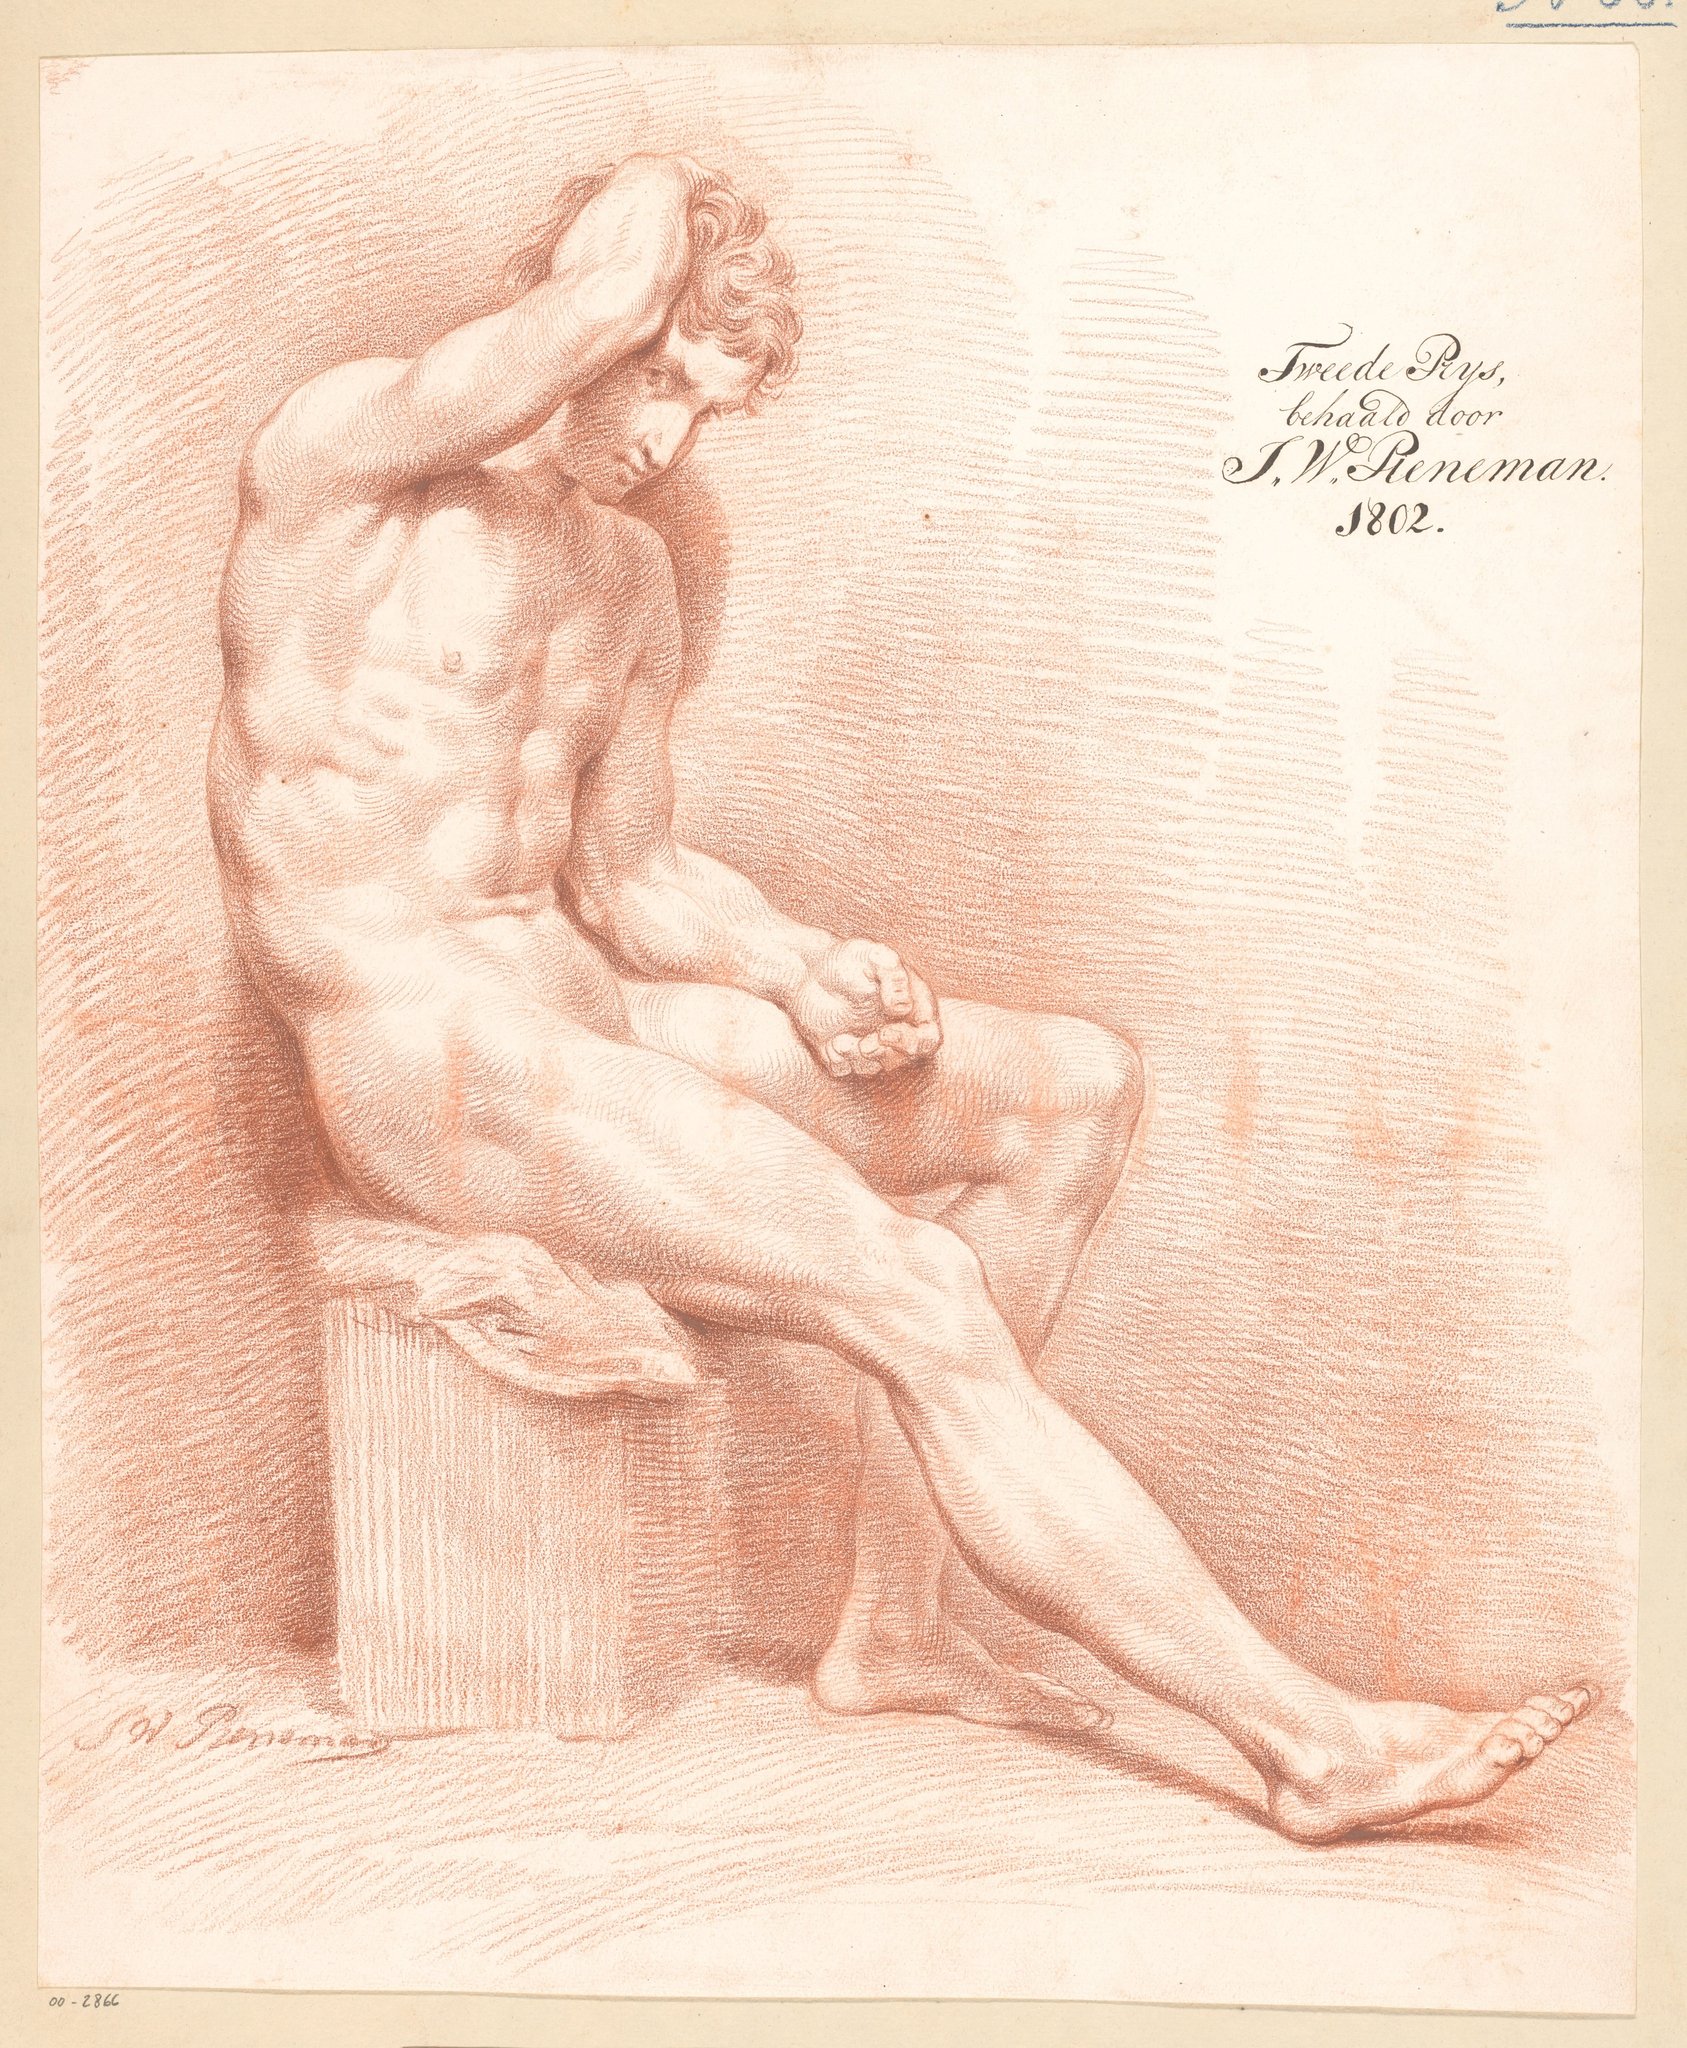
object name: drawing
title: Zittend mannelijk naakt, van opzij gezien (2e prijs 1802)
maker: jan willem pieneman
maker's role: draughtsman, painter, print maker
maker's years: 1779-1853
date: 1802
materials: chalk, charcoal, paper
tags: sitting figure (+ nude human being)